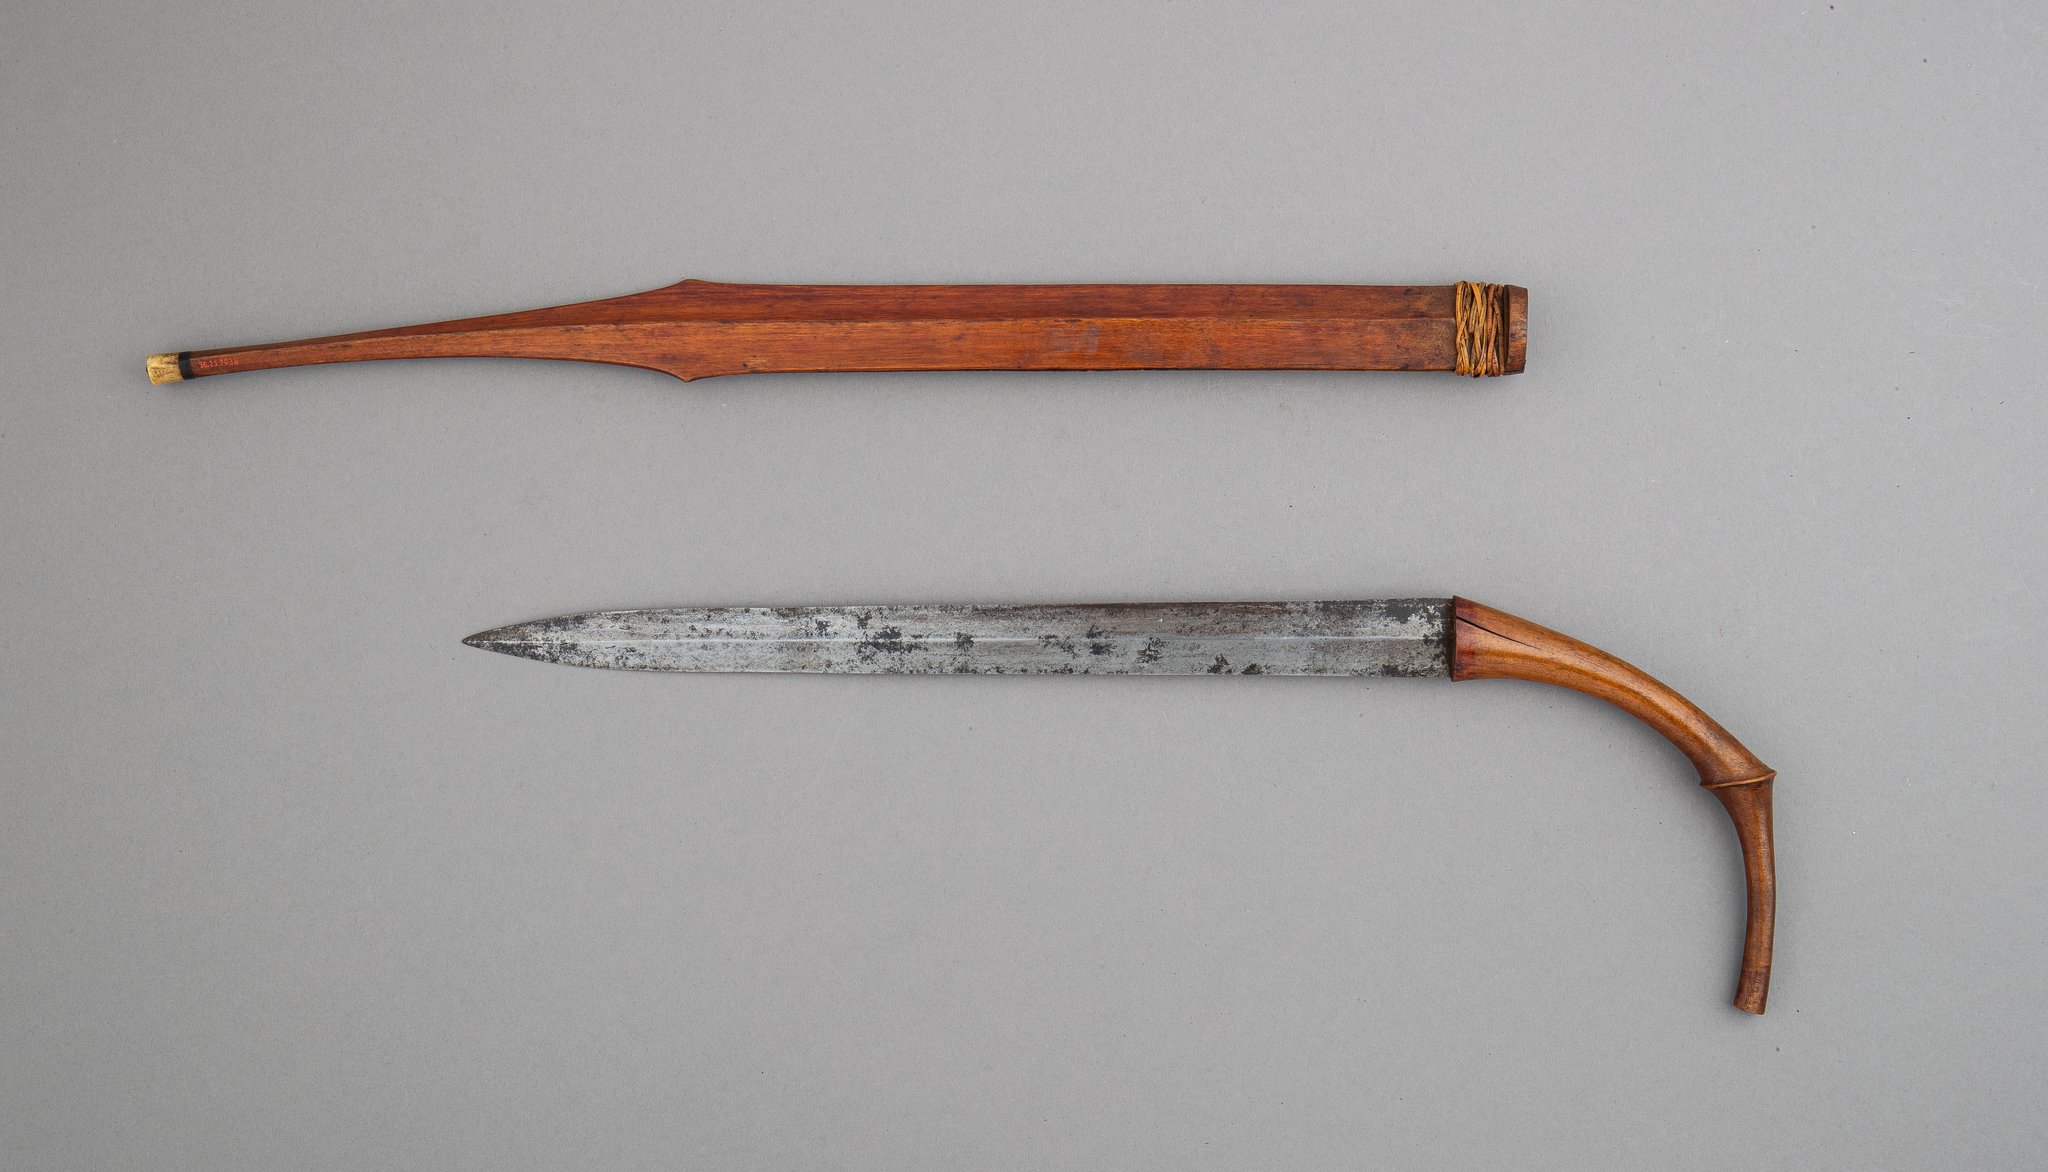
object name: dagger palitai with sheath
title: Dagger (Palitai) with Sheath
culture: mentawi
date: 1801-1900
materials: bone, steel, wood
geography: indonesia